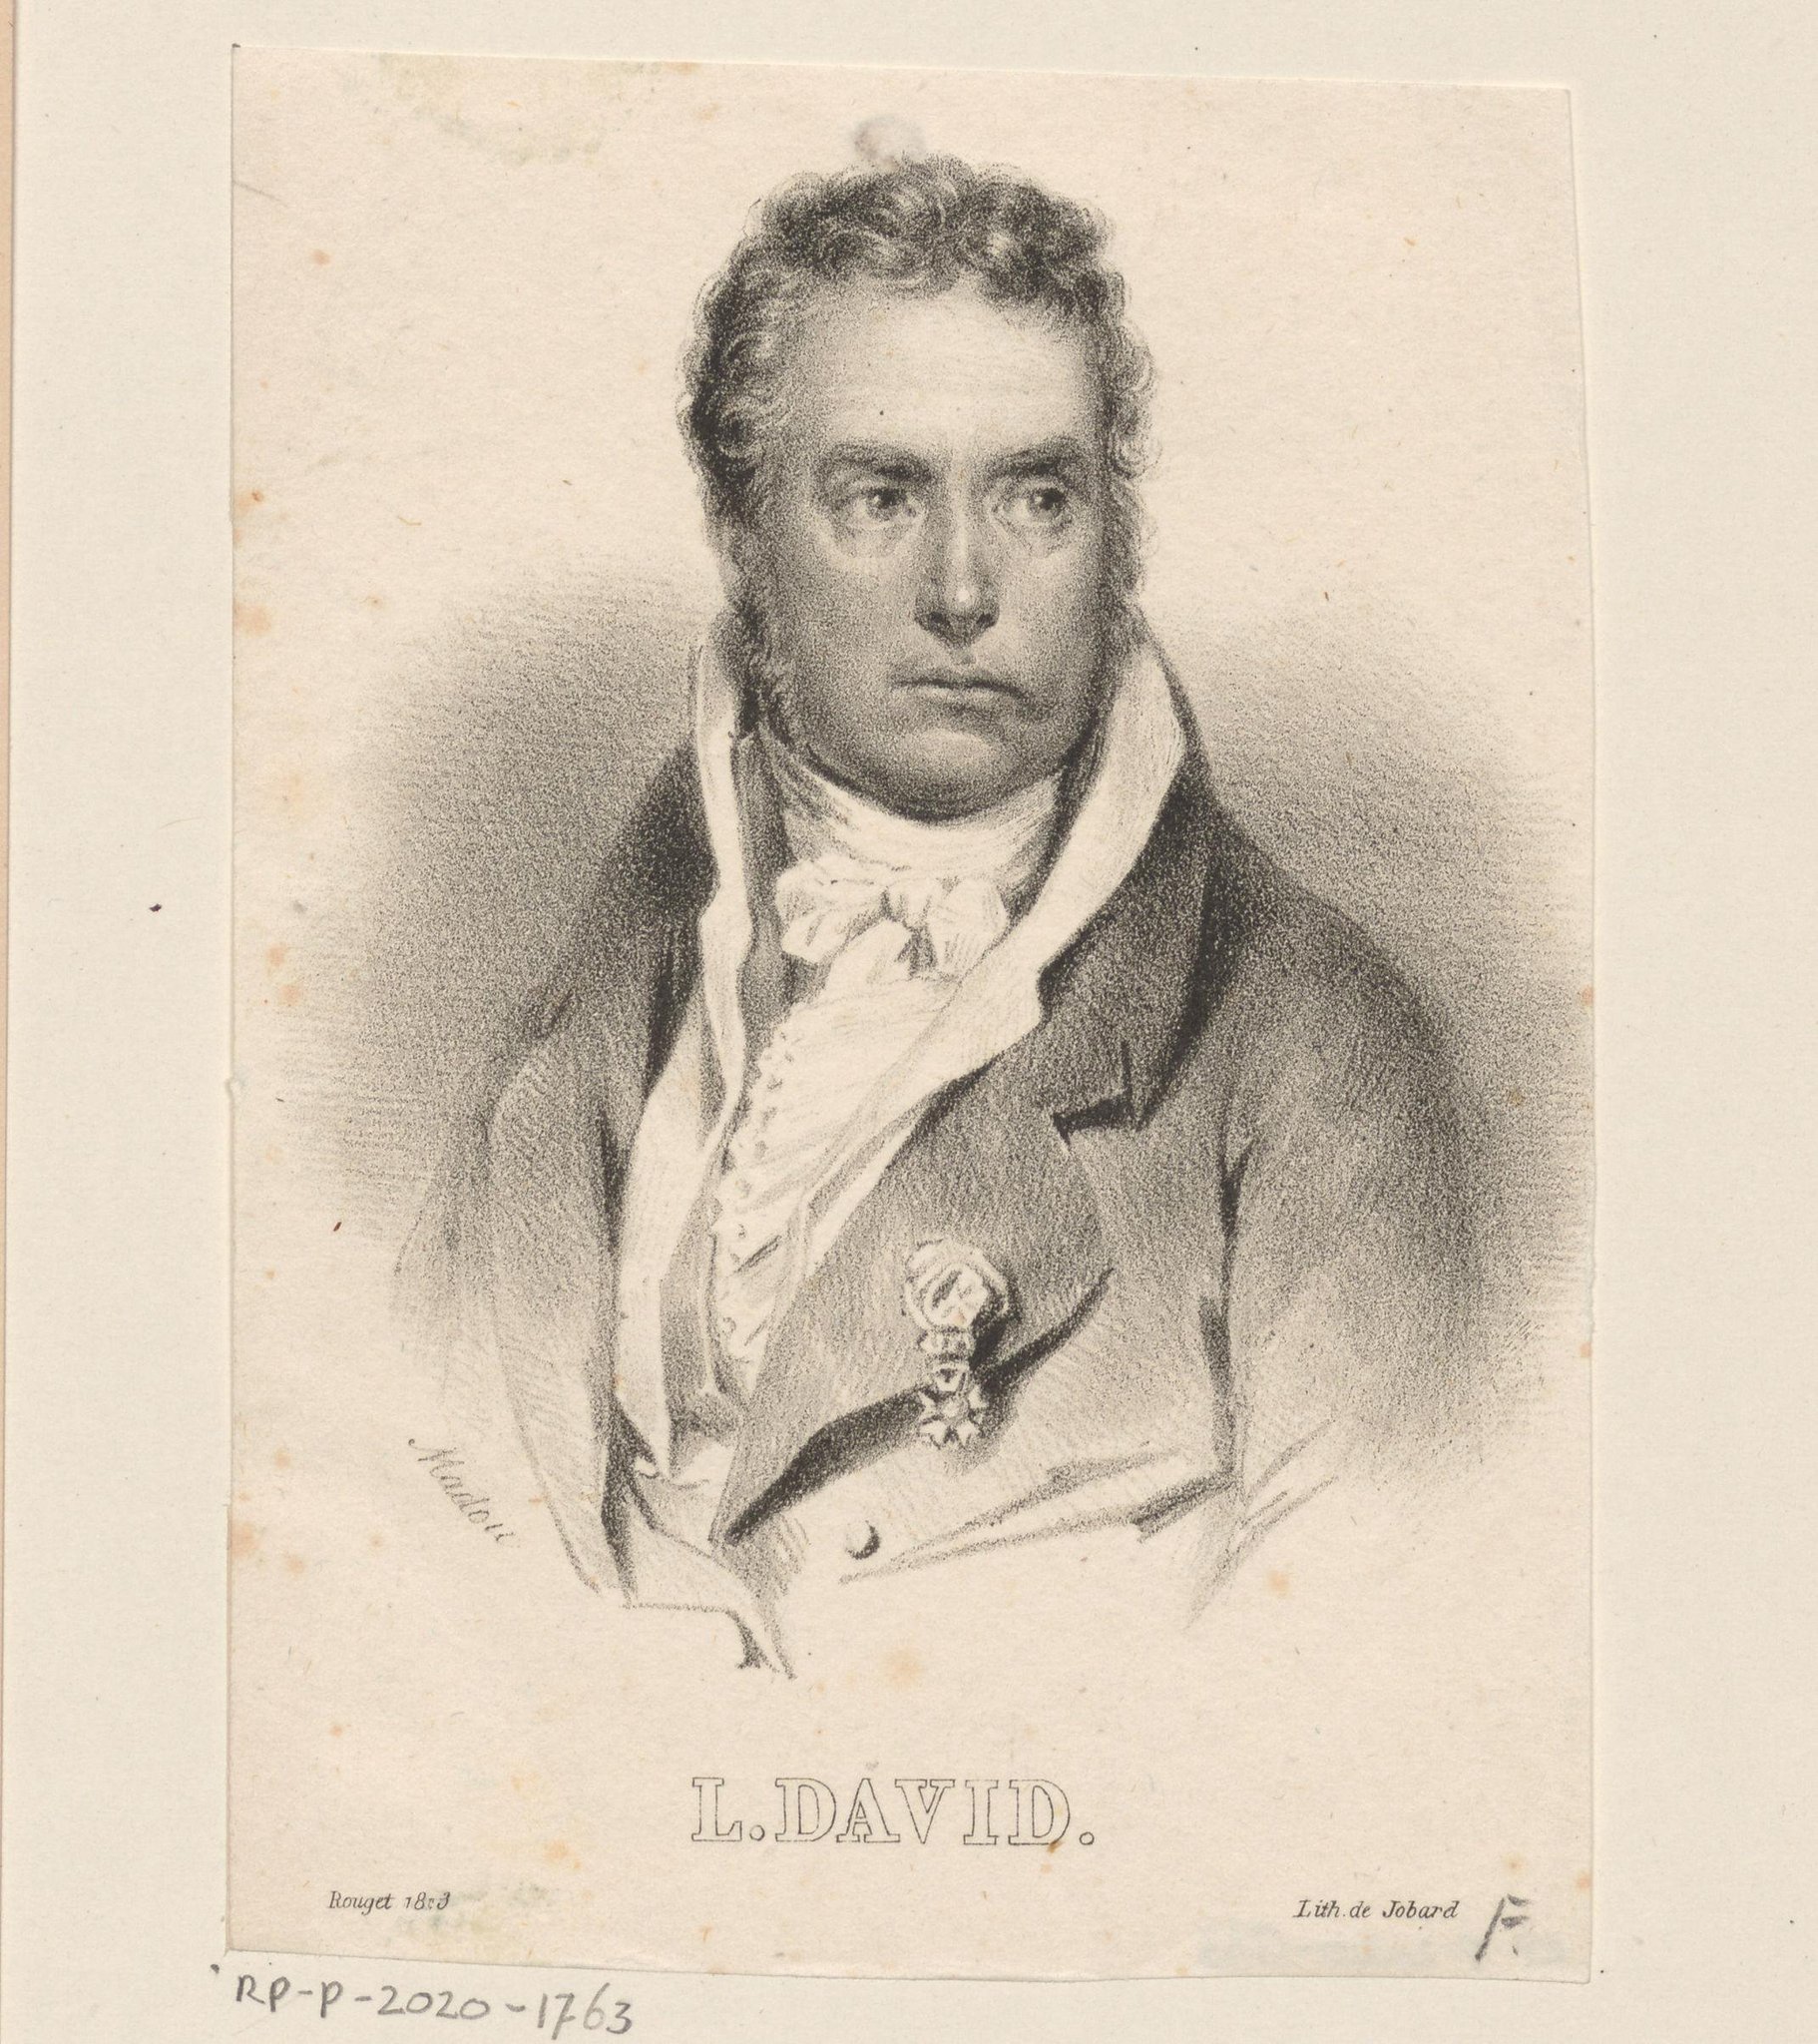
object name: print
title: Portret van Jacques-Louis David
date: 1813-1827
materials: paper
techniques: lithograph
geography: brussels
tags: paris, painter, draughtsman, jacques-louis david, historical persons, portrait, self-portrait of painter